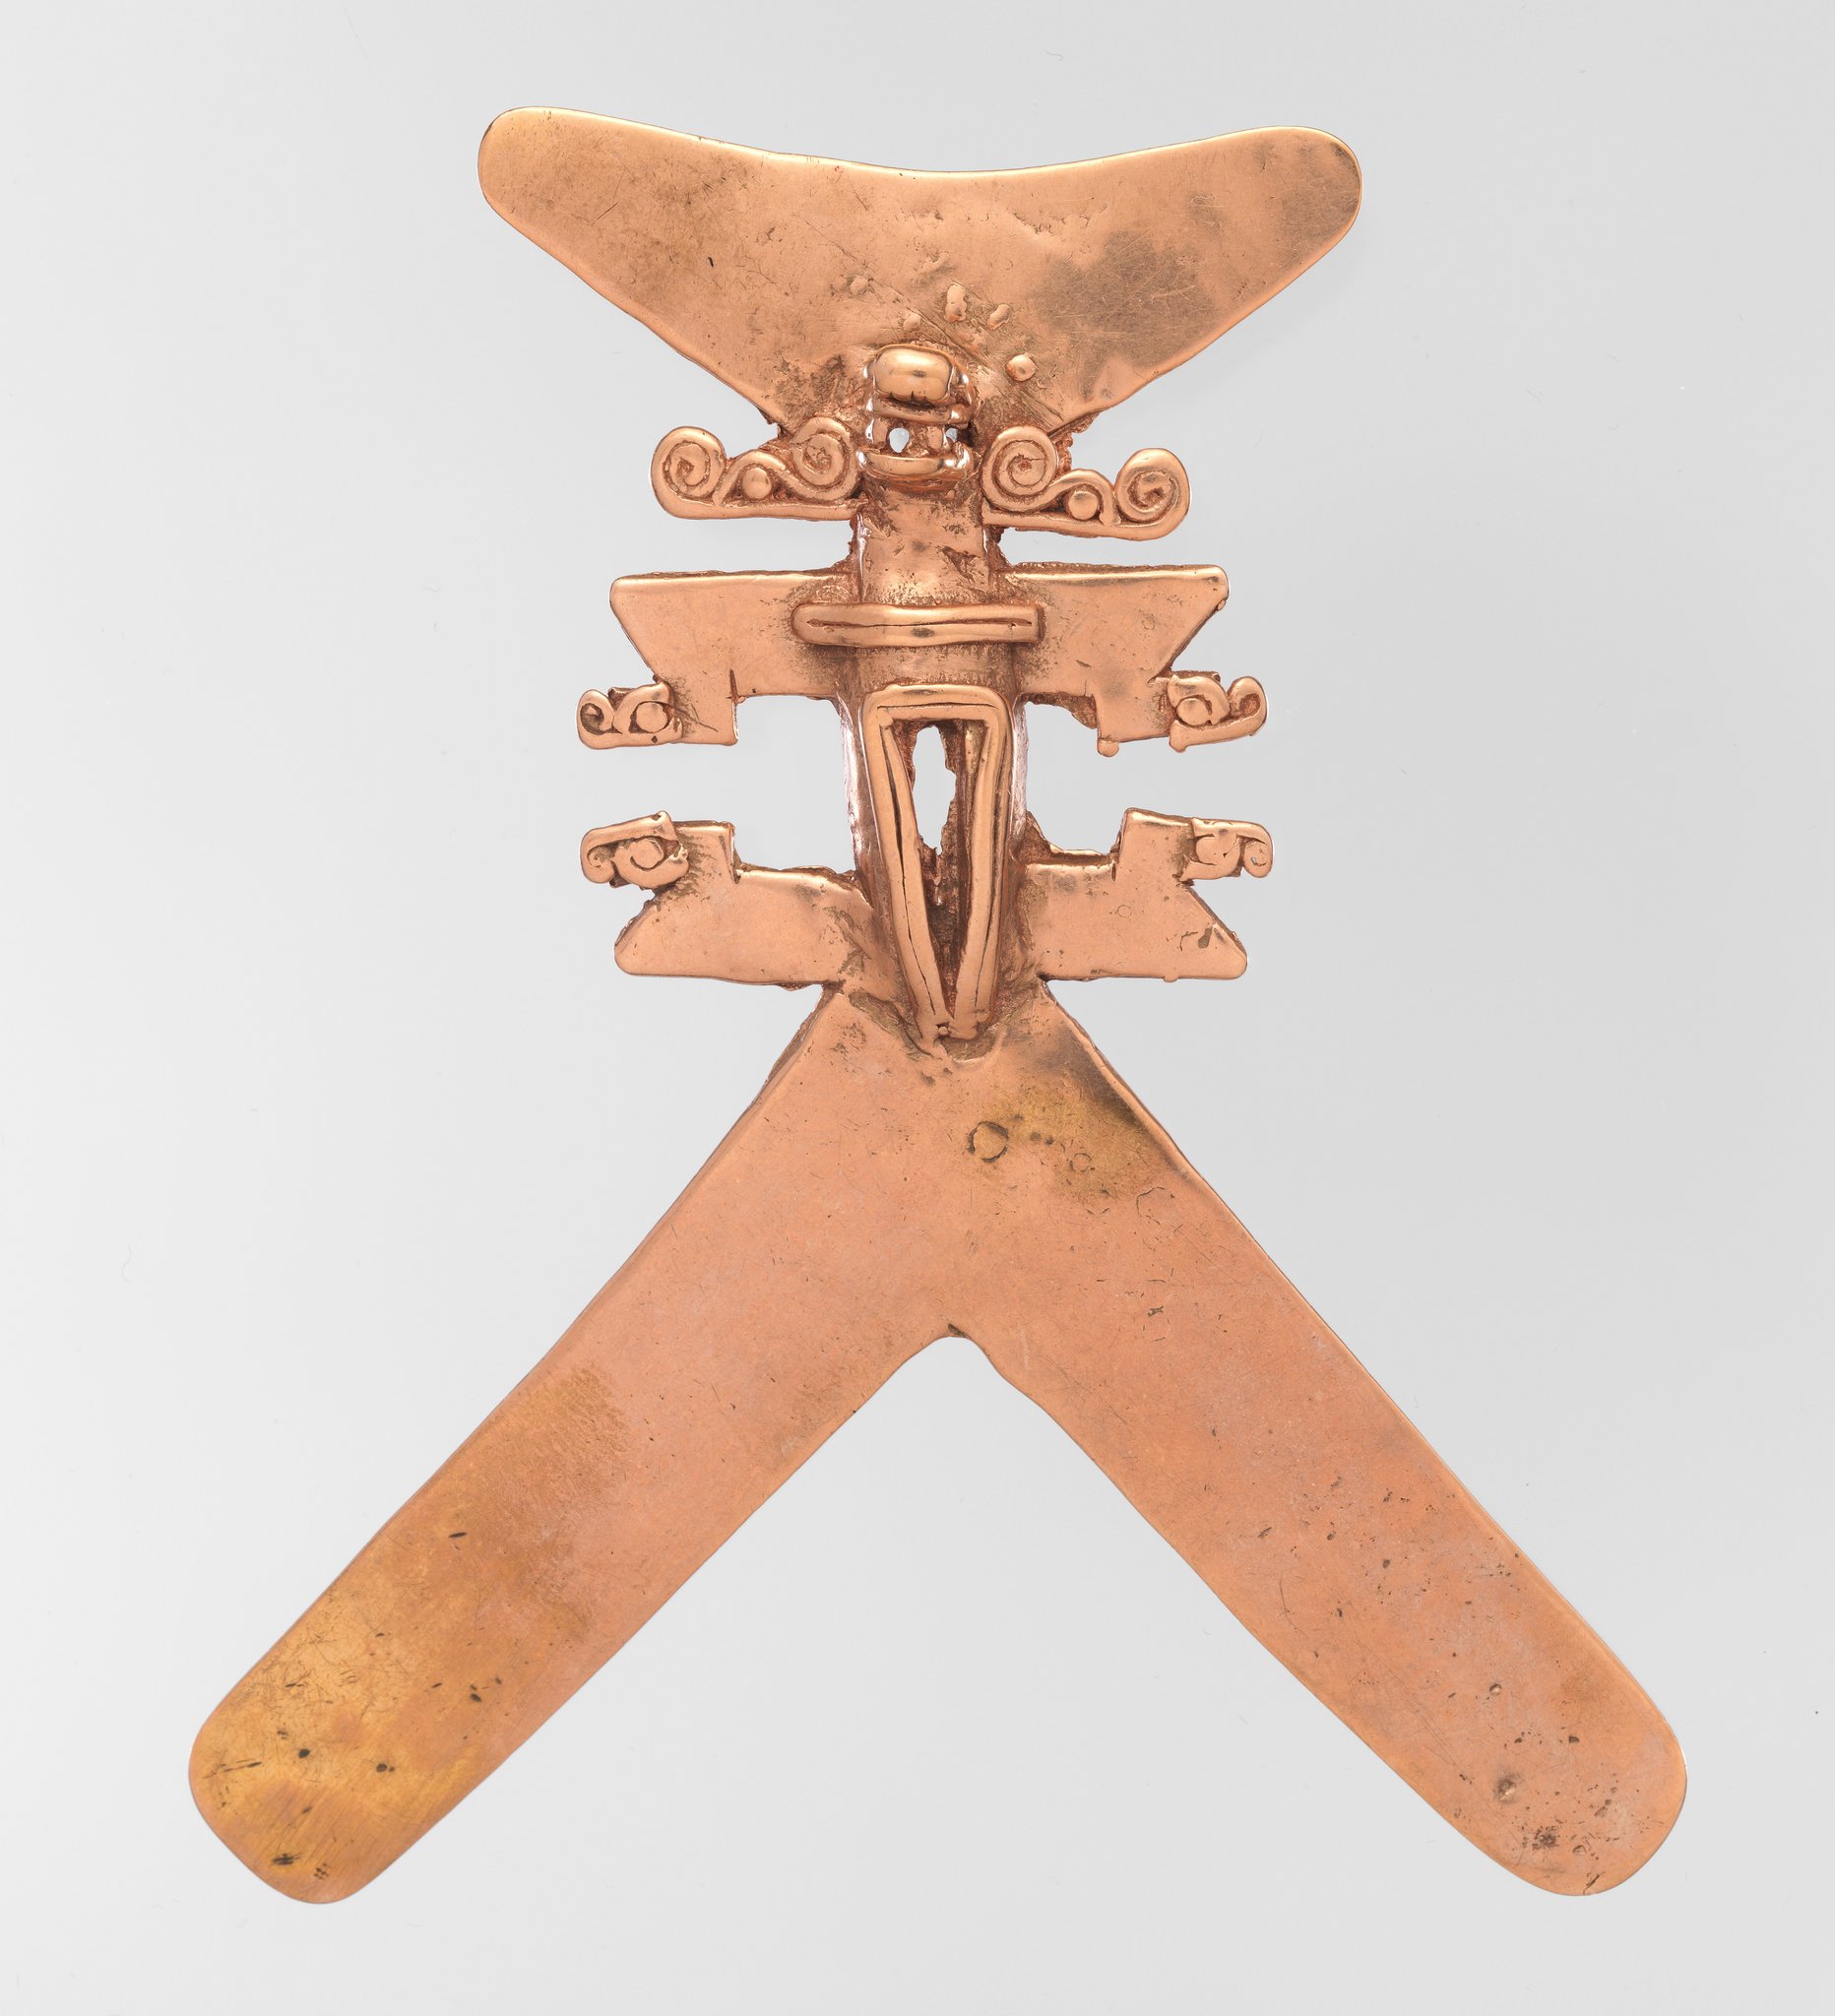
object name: pendant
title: Stylized Figure Pendant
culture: atlantic watershed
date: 1001-1600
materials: gold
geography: costa rica